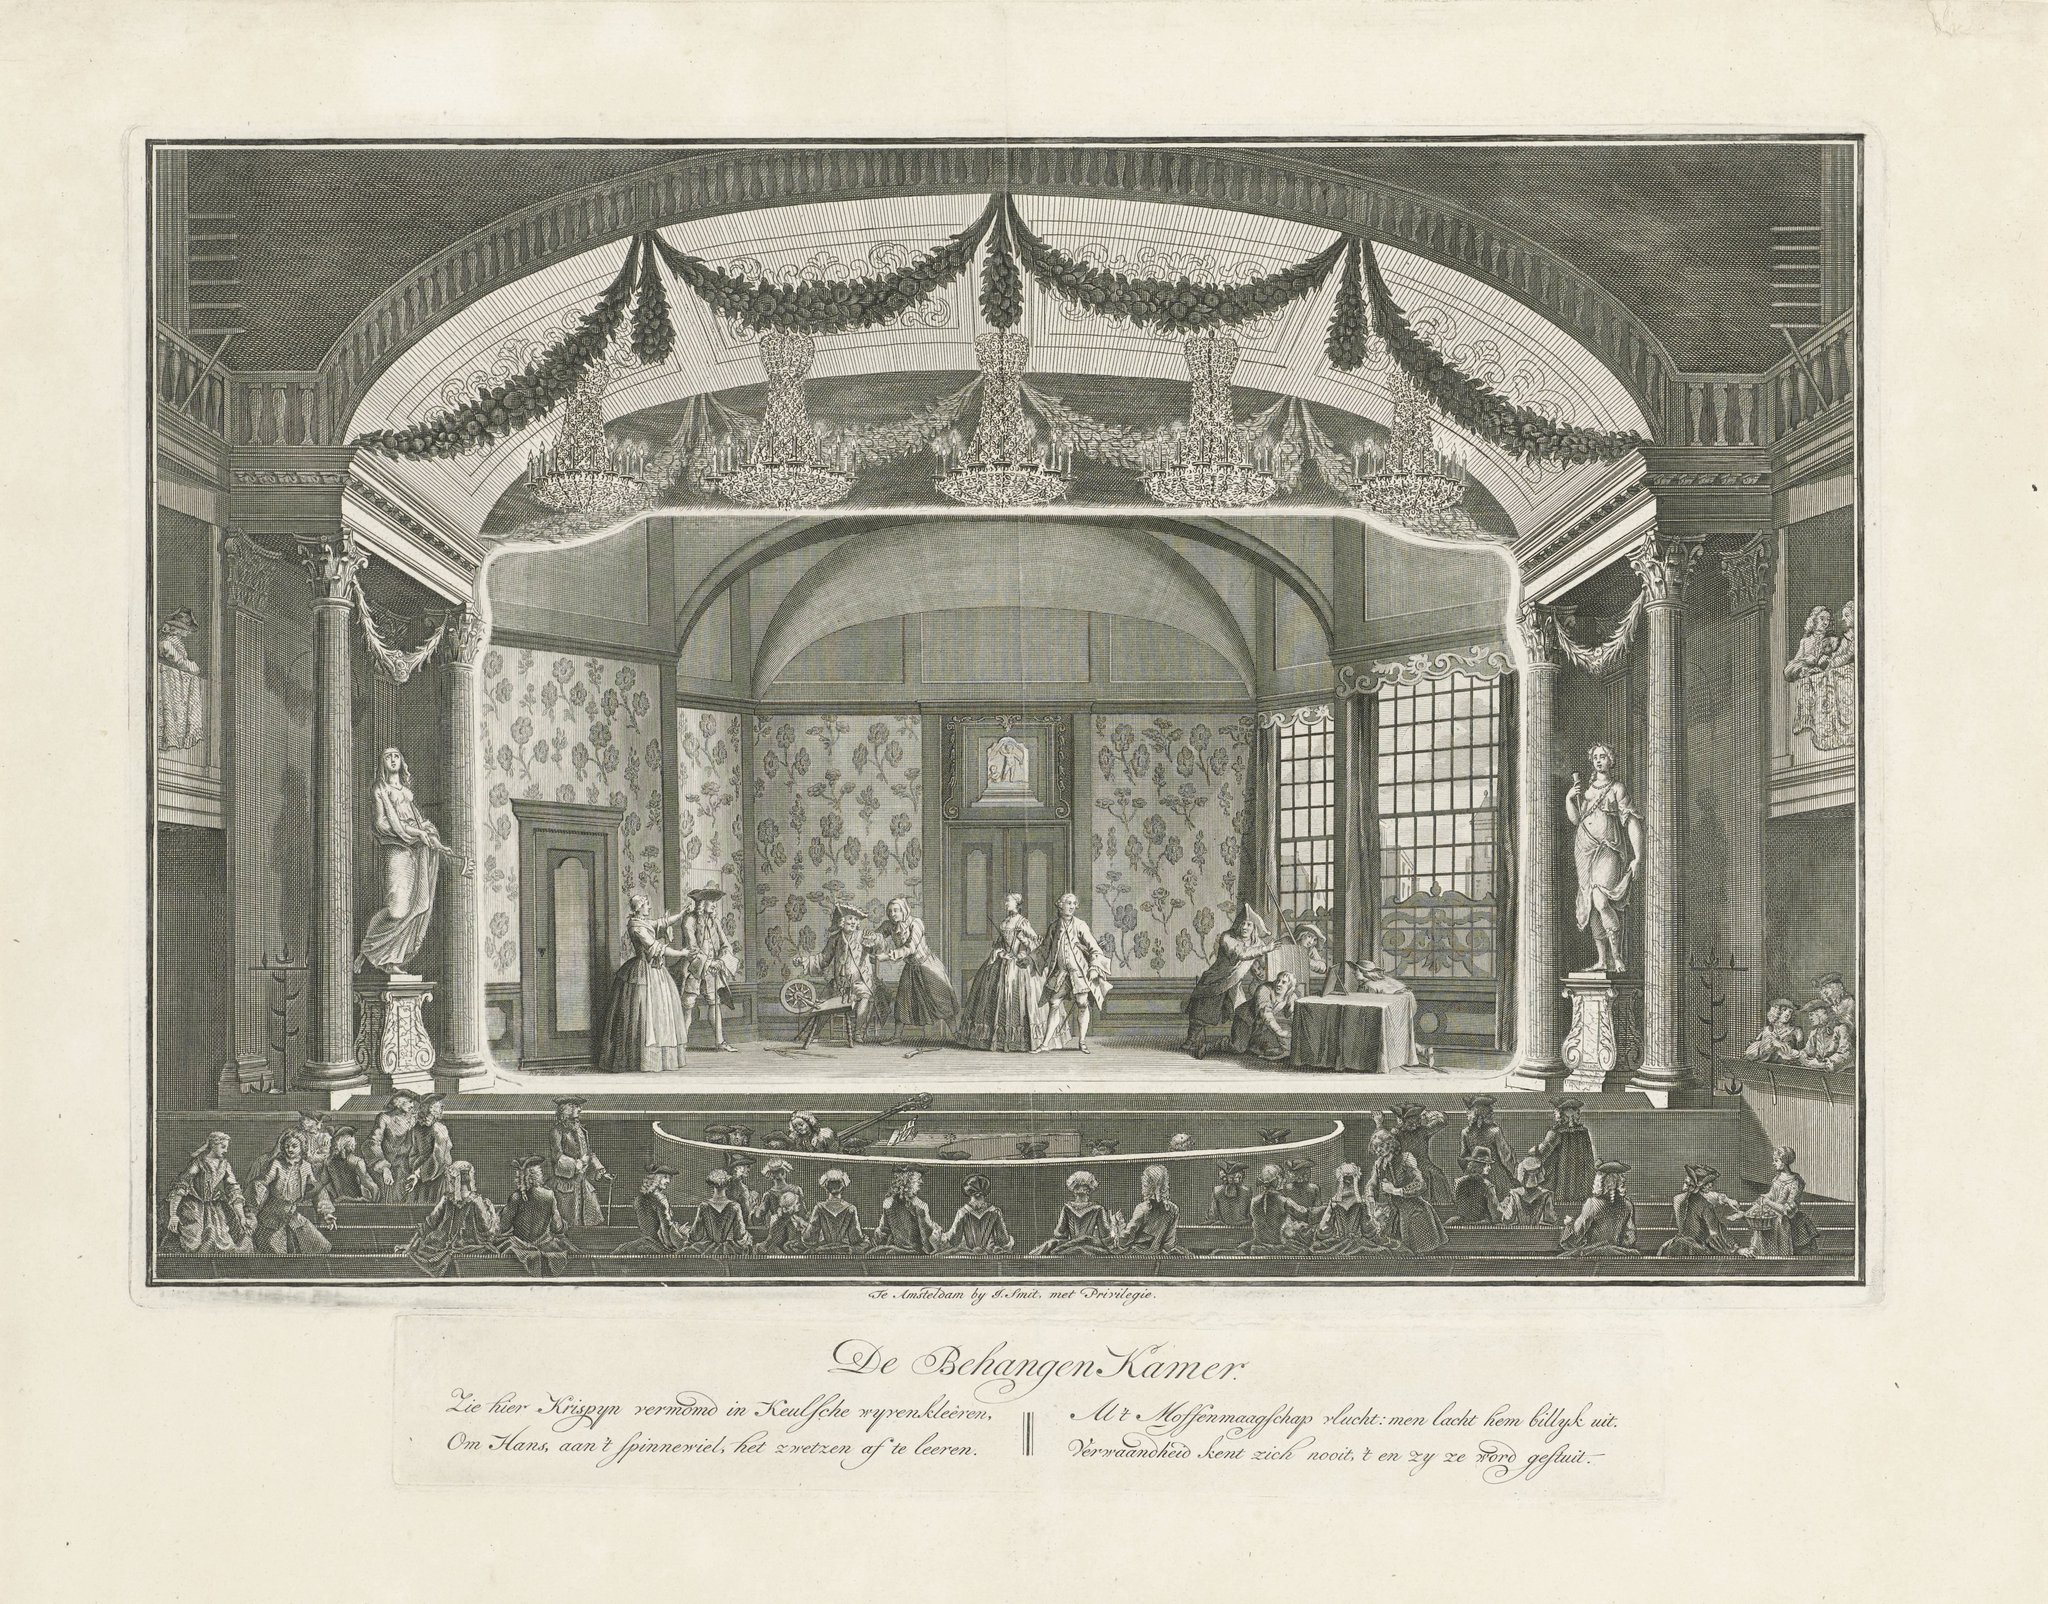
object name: print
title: De Behangen Kamer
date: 1760-1765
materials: paper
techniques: engraving, etching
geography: amsterdam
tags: theatre, theatrical performance, stage design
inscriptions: collector's mark: Lugt 2228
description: Toneelvoorstelling in de Amsterdamse Schouwburg op de Keizersgracht met het coulissendecor De Behangen Kamer met scène uit: De Zwetser. Het decor gedrukt van een aparte plaat binnen een passe-partout met de zaal, zijloges, orkestbak en de façade van het toneel met zuilen, guirlandes en kroonluchters. De titel en een vierregelig vers ook gedrukt van een aparte plaat. Onderdeel van een serie van 12 toneeldecors.